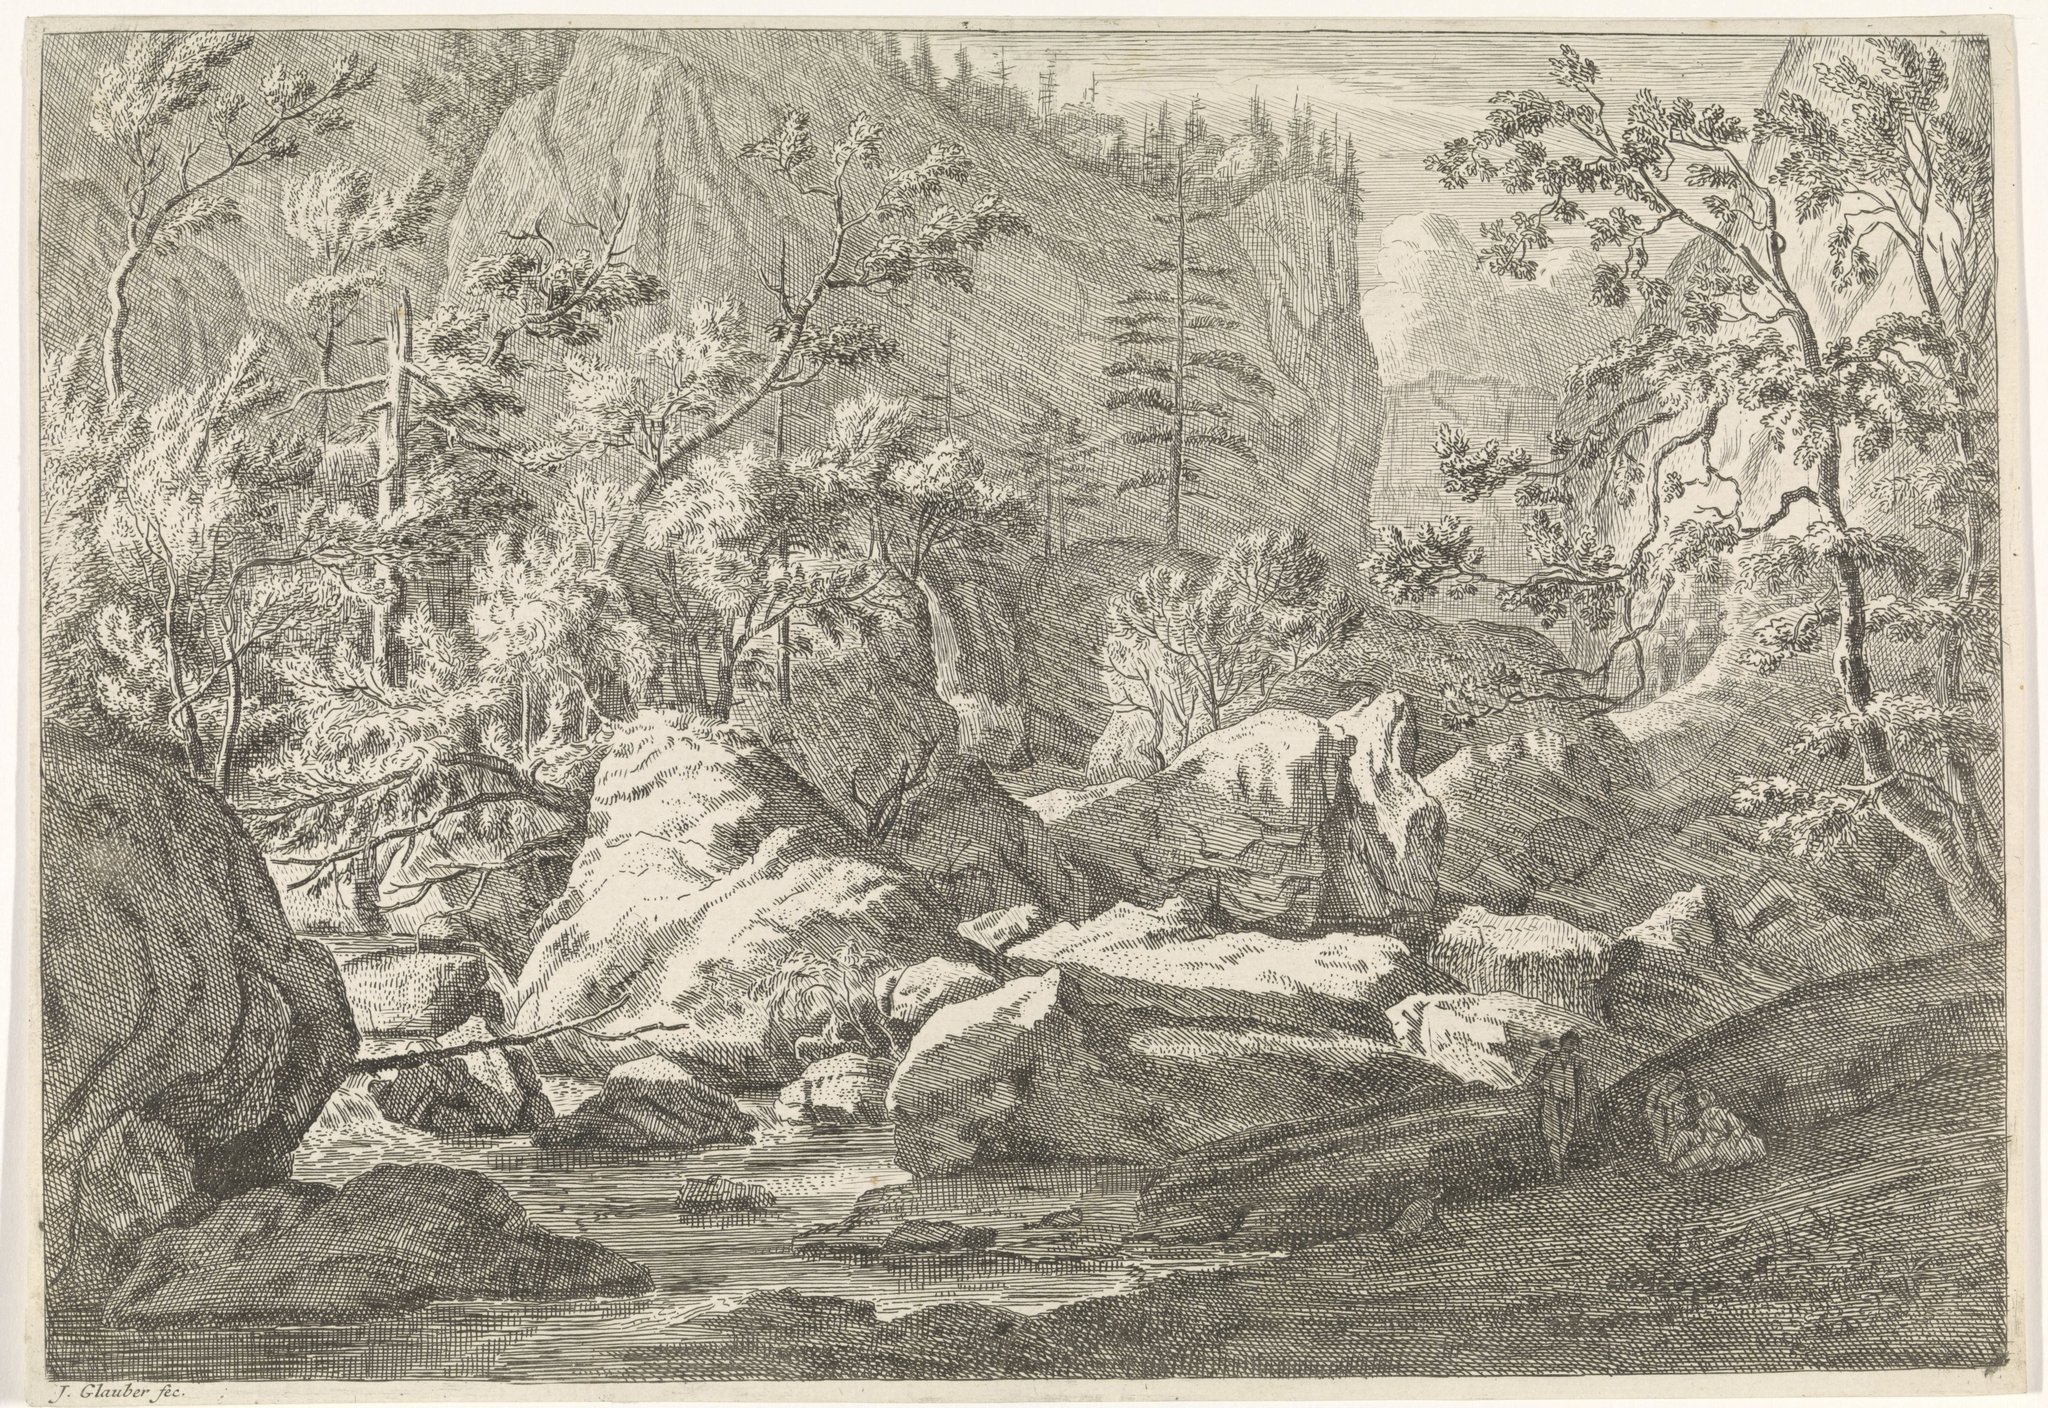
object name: print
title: Ravijn met rotsblokken en bomen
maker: johannes glauber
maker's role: draughtsman, painter, print maker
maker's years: 1646-1726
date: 1656-1726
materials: paper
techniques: etching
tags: rock-formations, ravine, chasm, abyss, canyon (+ landscape with figures, staffage)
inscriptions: collector's mark: Lugt 2228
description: Gezicht op een ravijn. Op de voorgrond een rivier met aan de oevers enkele zittende figuren. De prent maakt deel uit van een serie met berglandschappen in het Chartreuzer-gebergte..